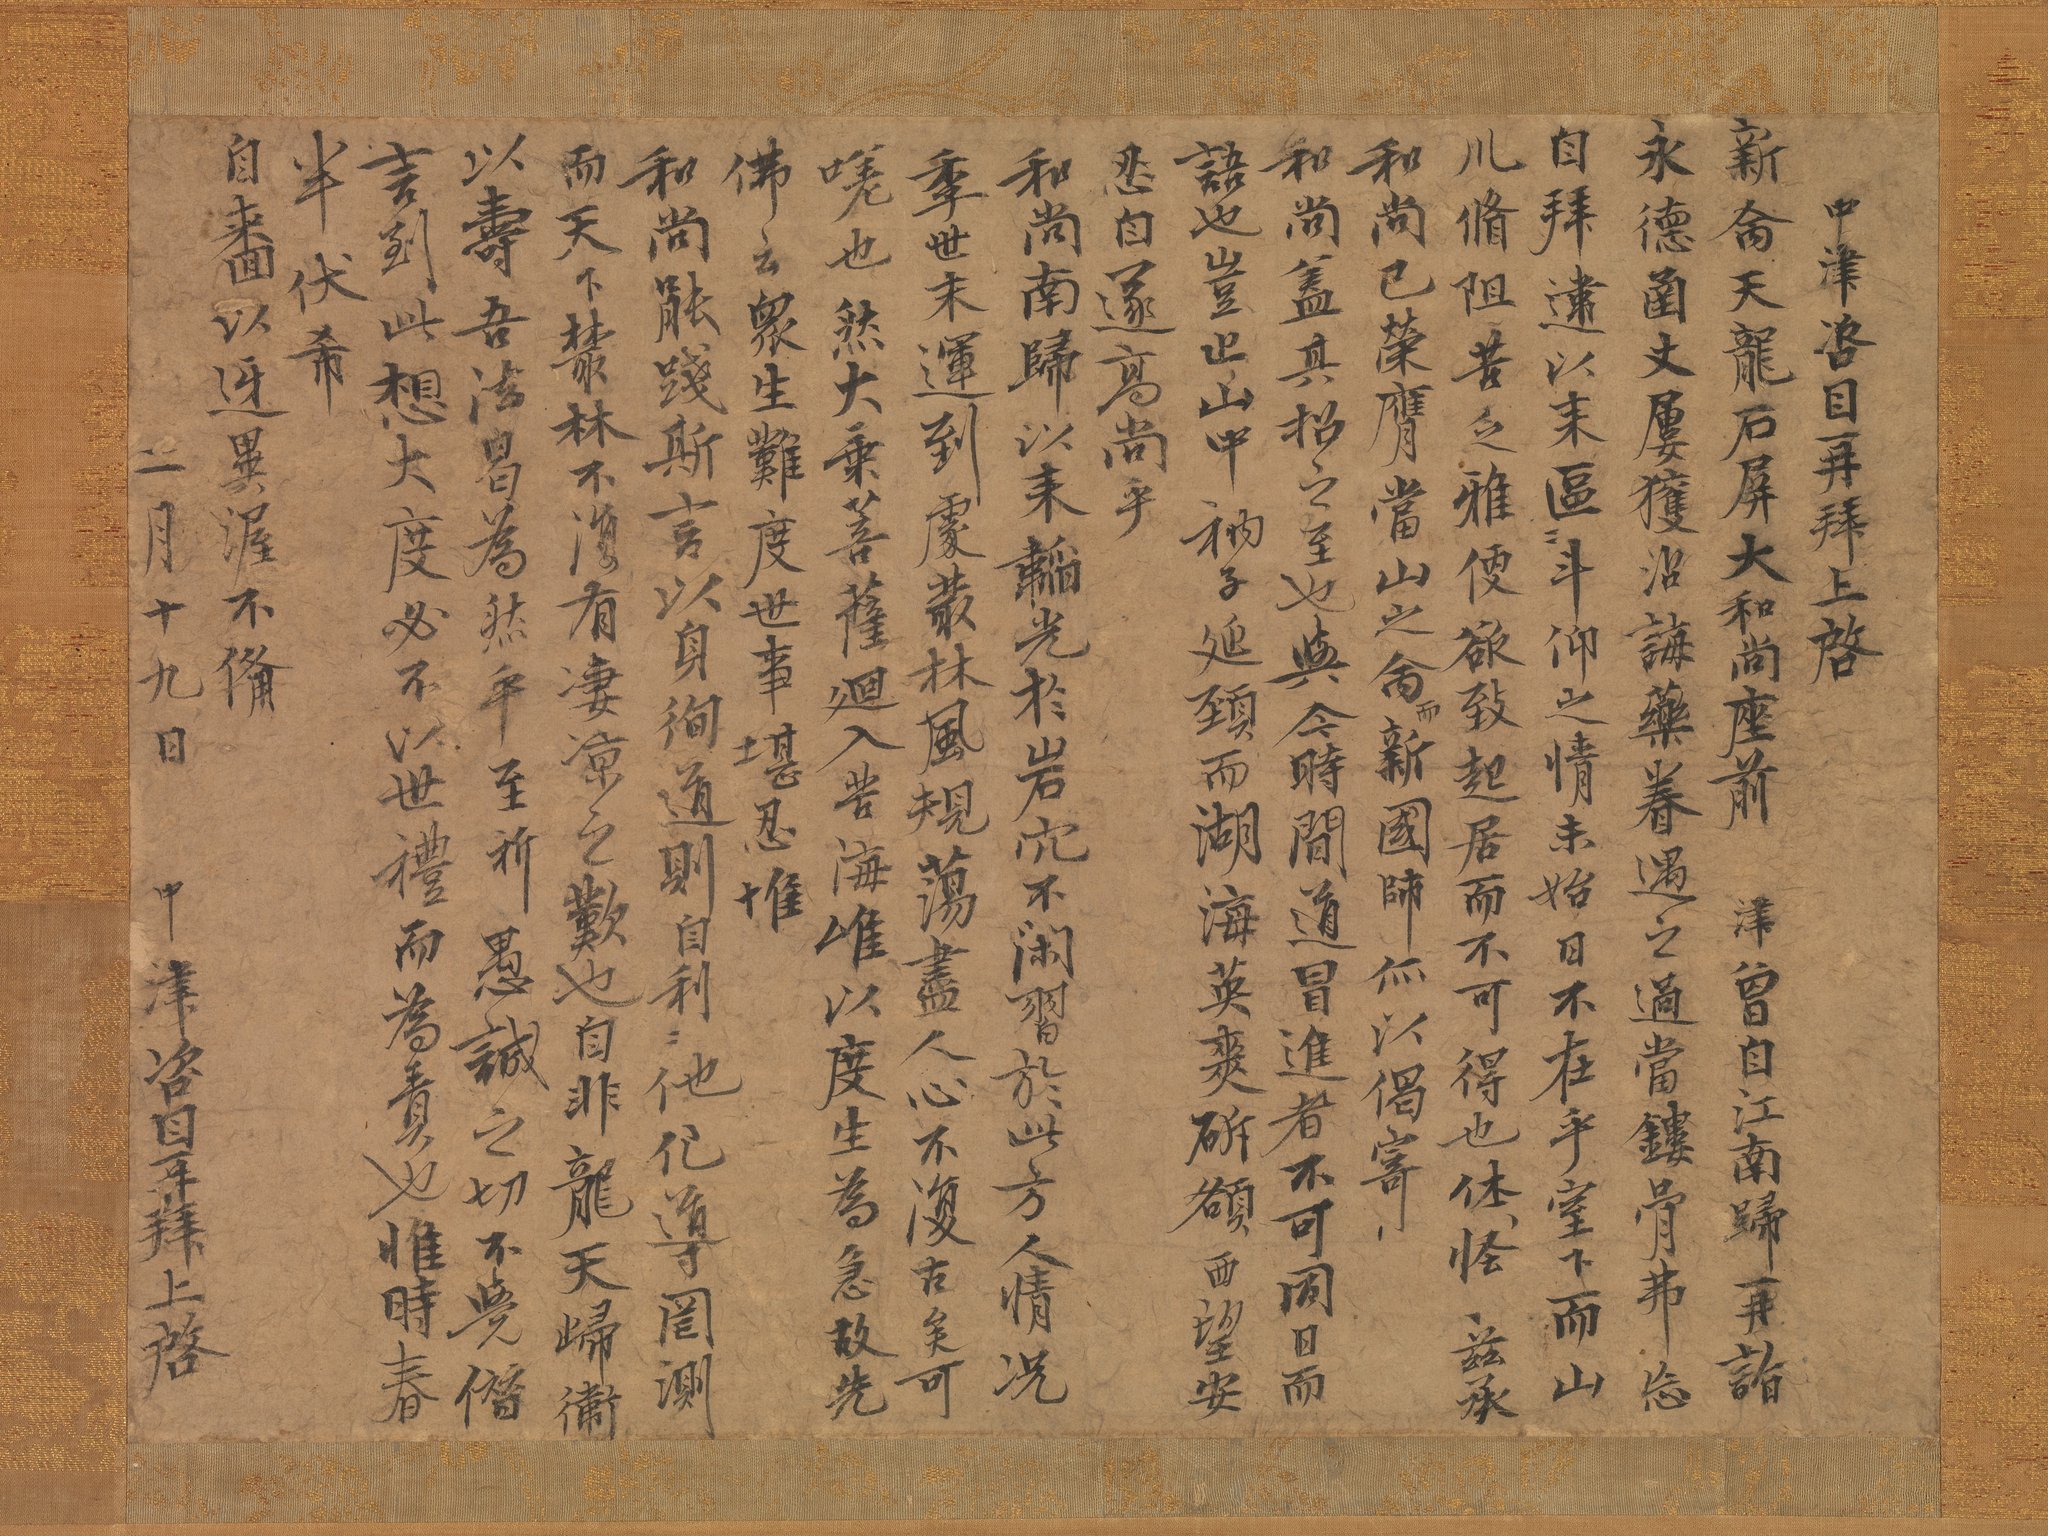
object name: hanging scroll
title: Letter to Monk Sekibyō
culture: japanese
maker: zekkai chūshin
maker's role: artist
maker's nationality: japanese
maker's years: 1336-1405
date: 1301-1400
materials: ink, paper